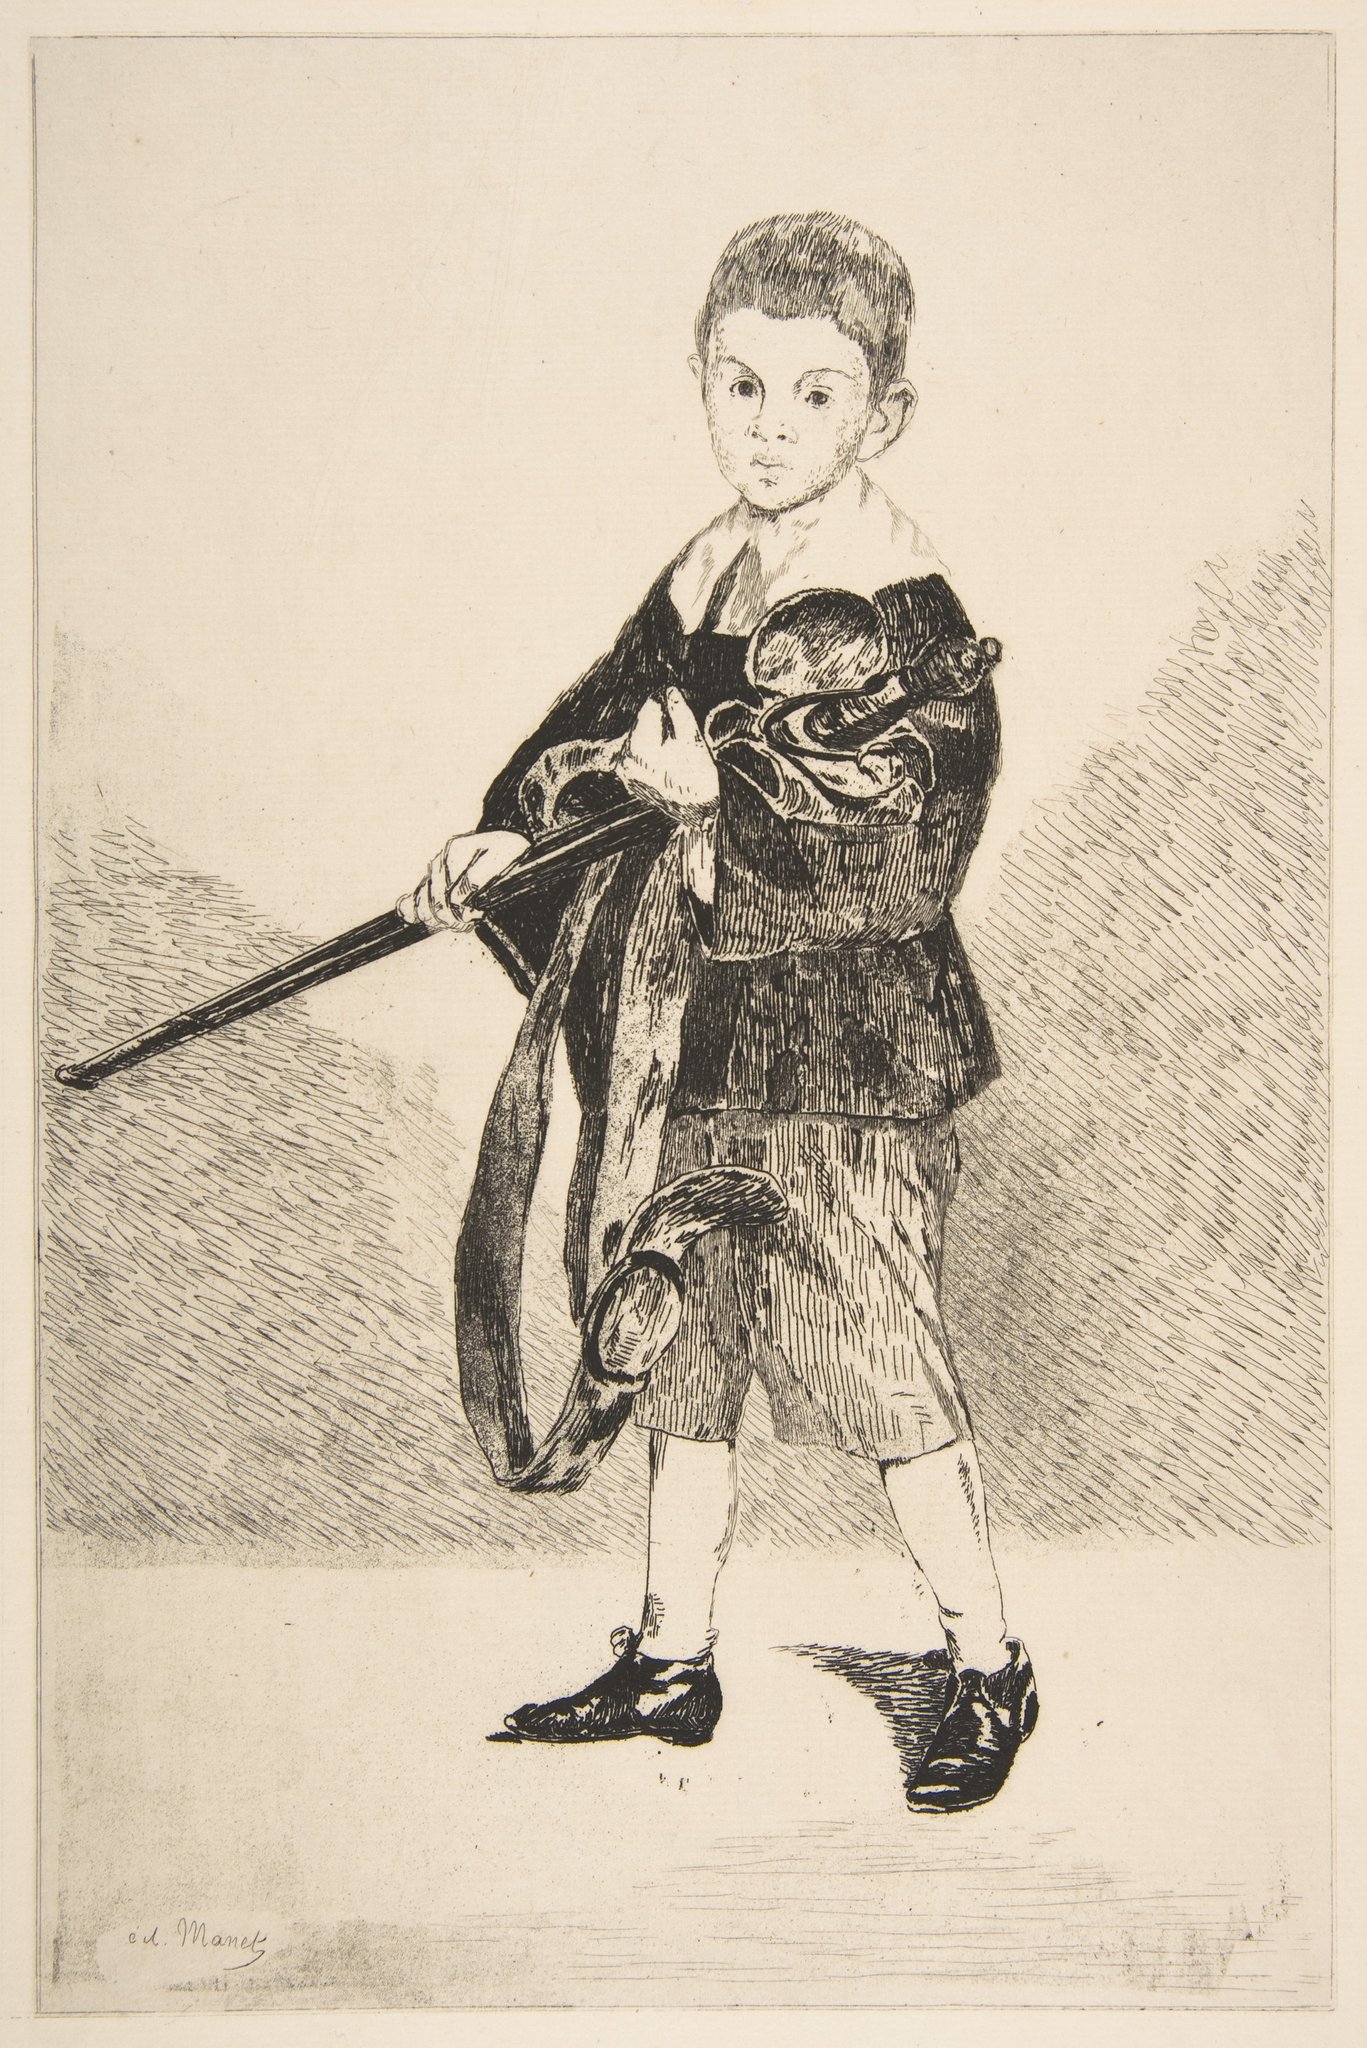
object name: print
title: Boy with a Sword, Turned Left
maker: édouard manet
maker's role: artist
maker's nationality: french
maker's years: 1832-1883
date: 1862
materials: paper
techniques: aquatint, etching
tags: swords,boys